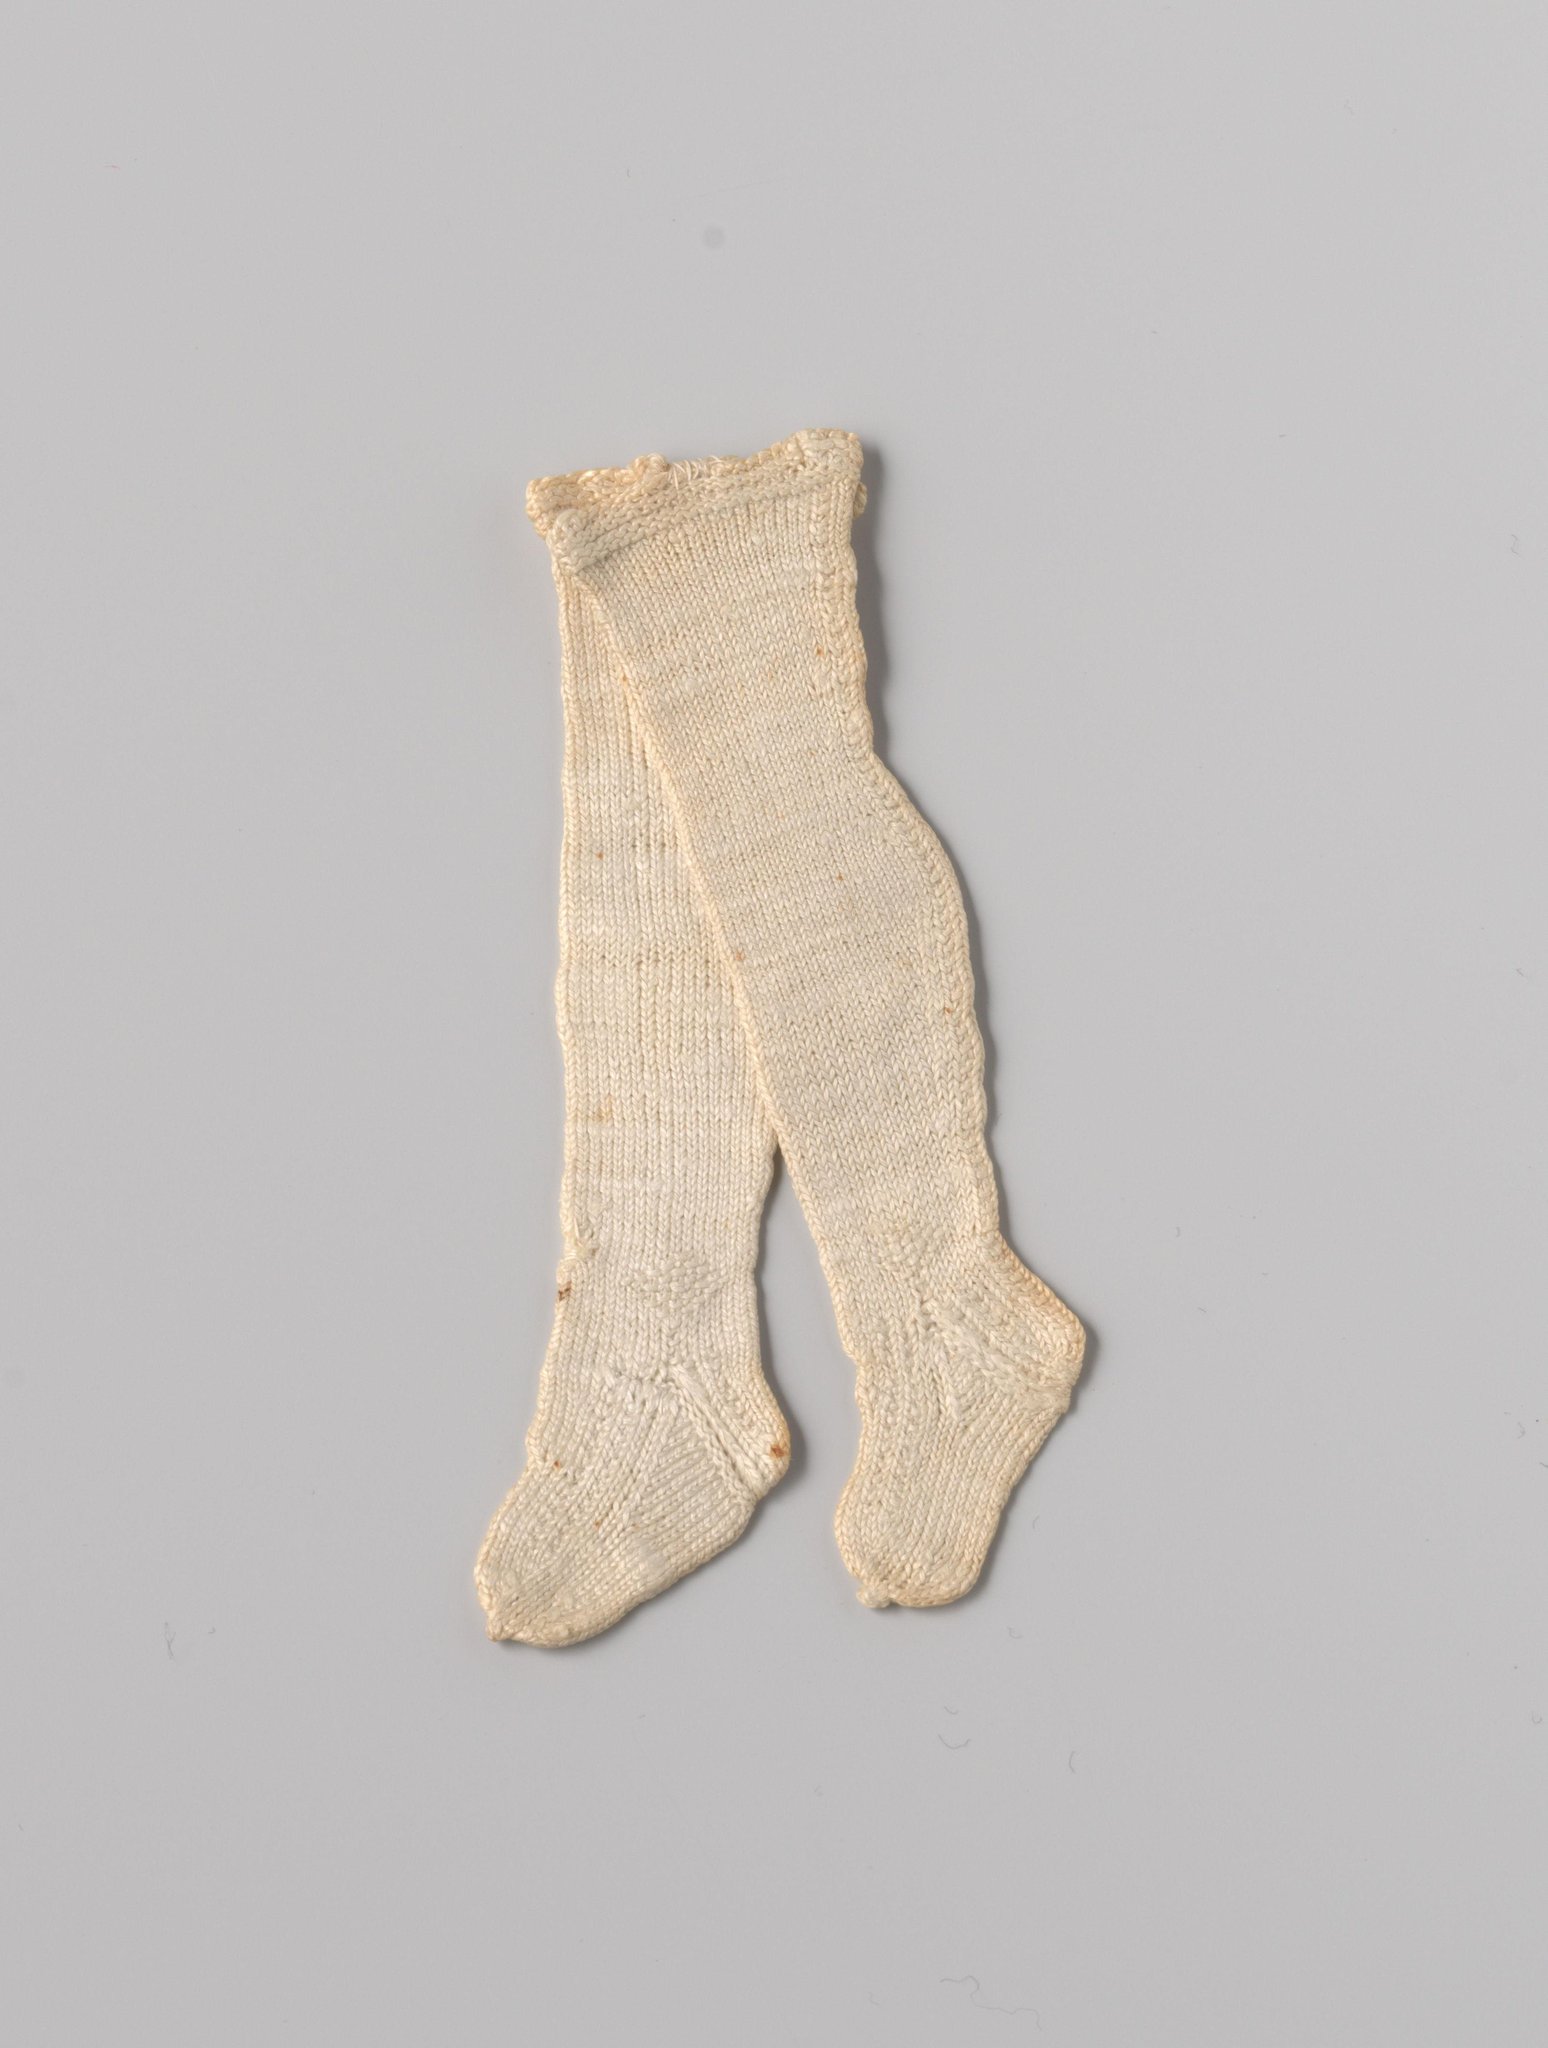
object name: stocking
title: Kous met een ruitmotief in gerstekorrelsteek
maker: Anonymous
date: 1690-1710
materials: linen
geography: amsterdam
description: De kous is gebreid van wit linnen, met een teenstuk, een kleine en een grote hiel, een kuit, middenachter een naad en ter hoogte van de enkel een ruitmotief in gestekorrelsteek.